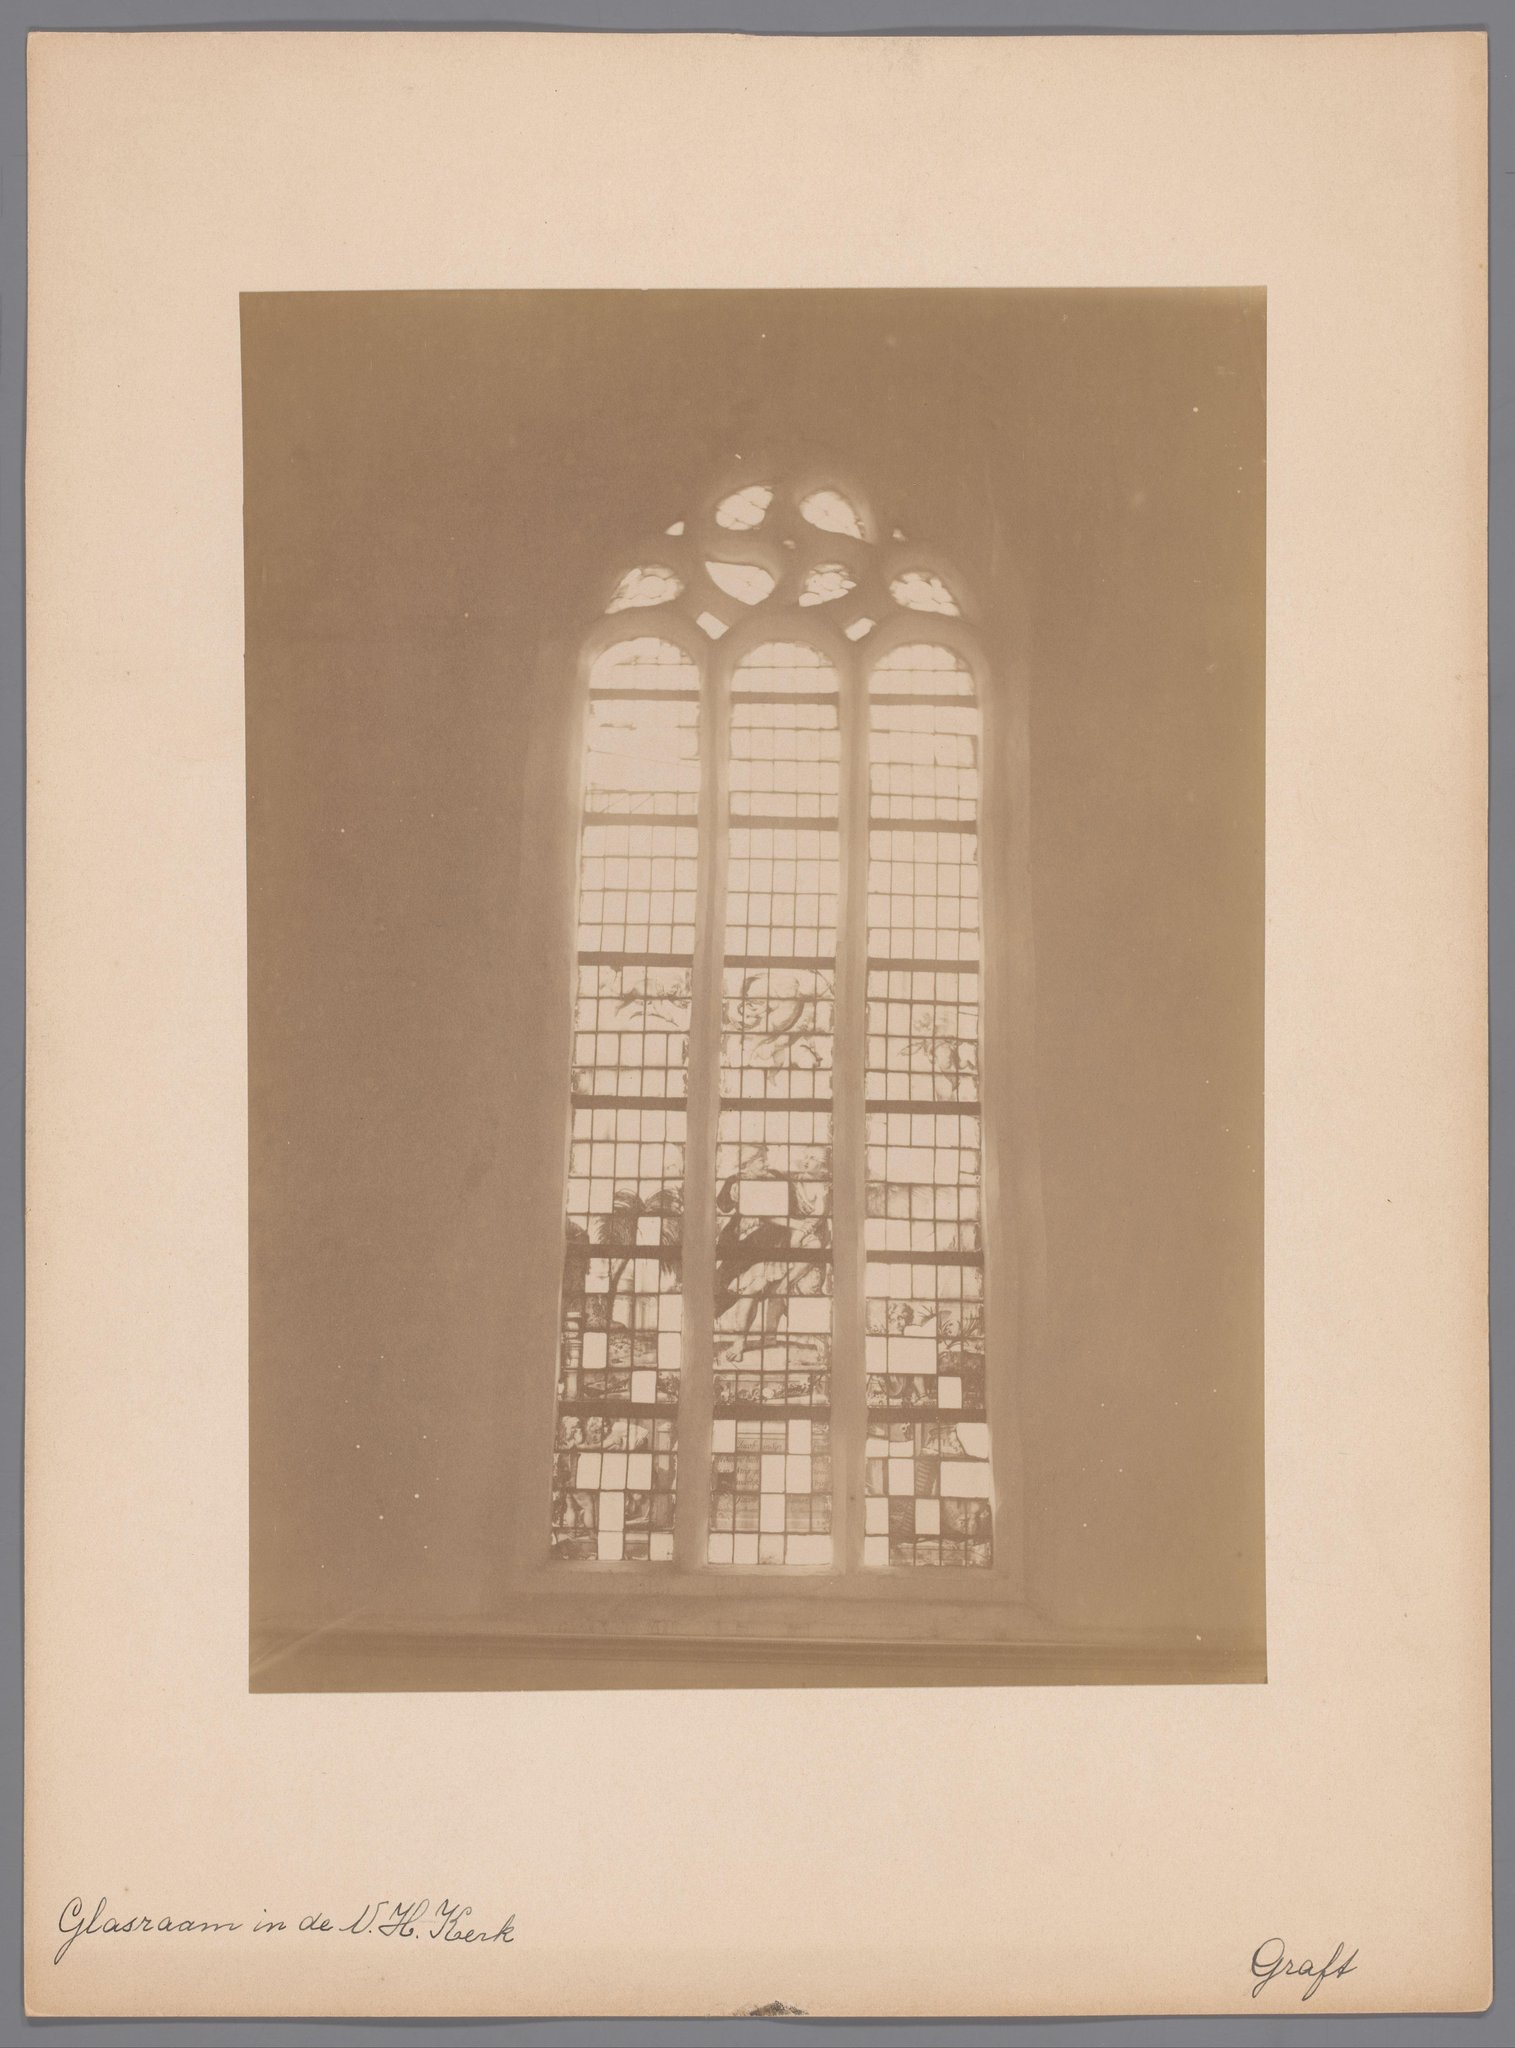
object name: photograph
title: Geschilderd raam in de Grote Kerk te Graft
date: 1890-1910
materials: cardboard, photographic support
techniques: albumen print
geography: grote kerk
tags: church-window, e.g. rose-window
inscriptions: annotation: ‘Graft/ glasraam in de Ned. Herv. Kerk’, annotation: ‘Glasraam in de N.H. Kerk/ Graft’